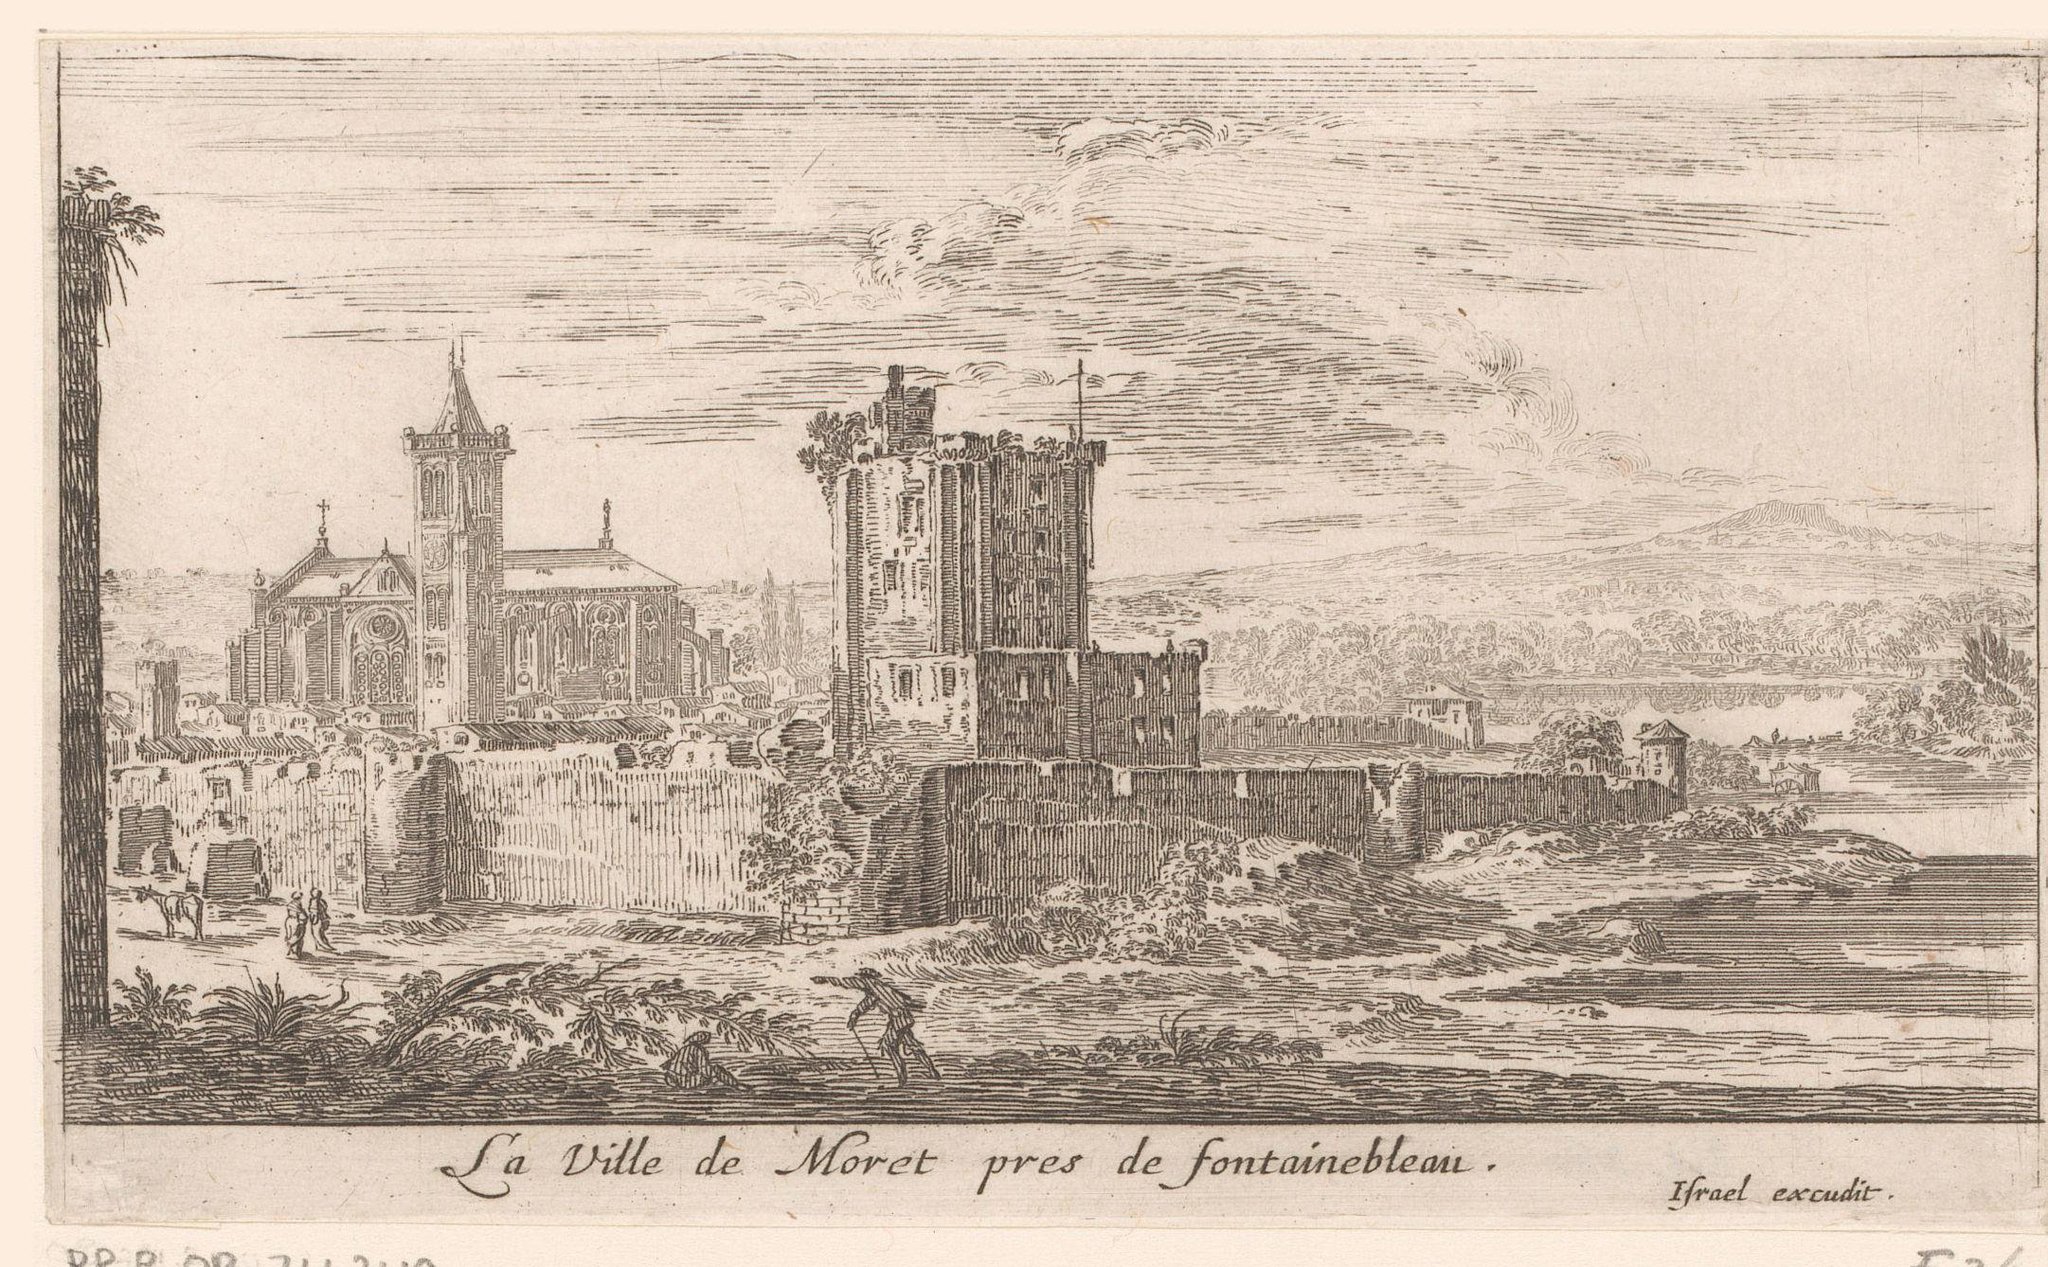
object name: print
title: Gezicht op het dorp Moret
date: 1631-1691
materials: paper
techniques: engraving, etching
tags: city-view, and landscape with man-made constructions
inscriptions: collector's mark: Lugt 240